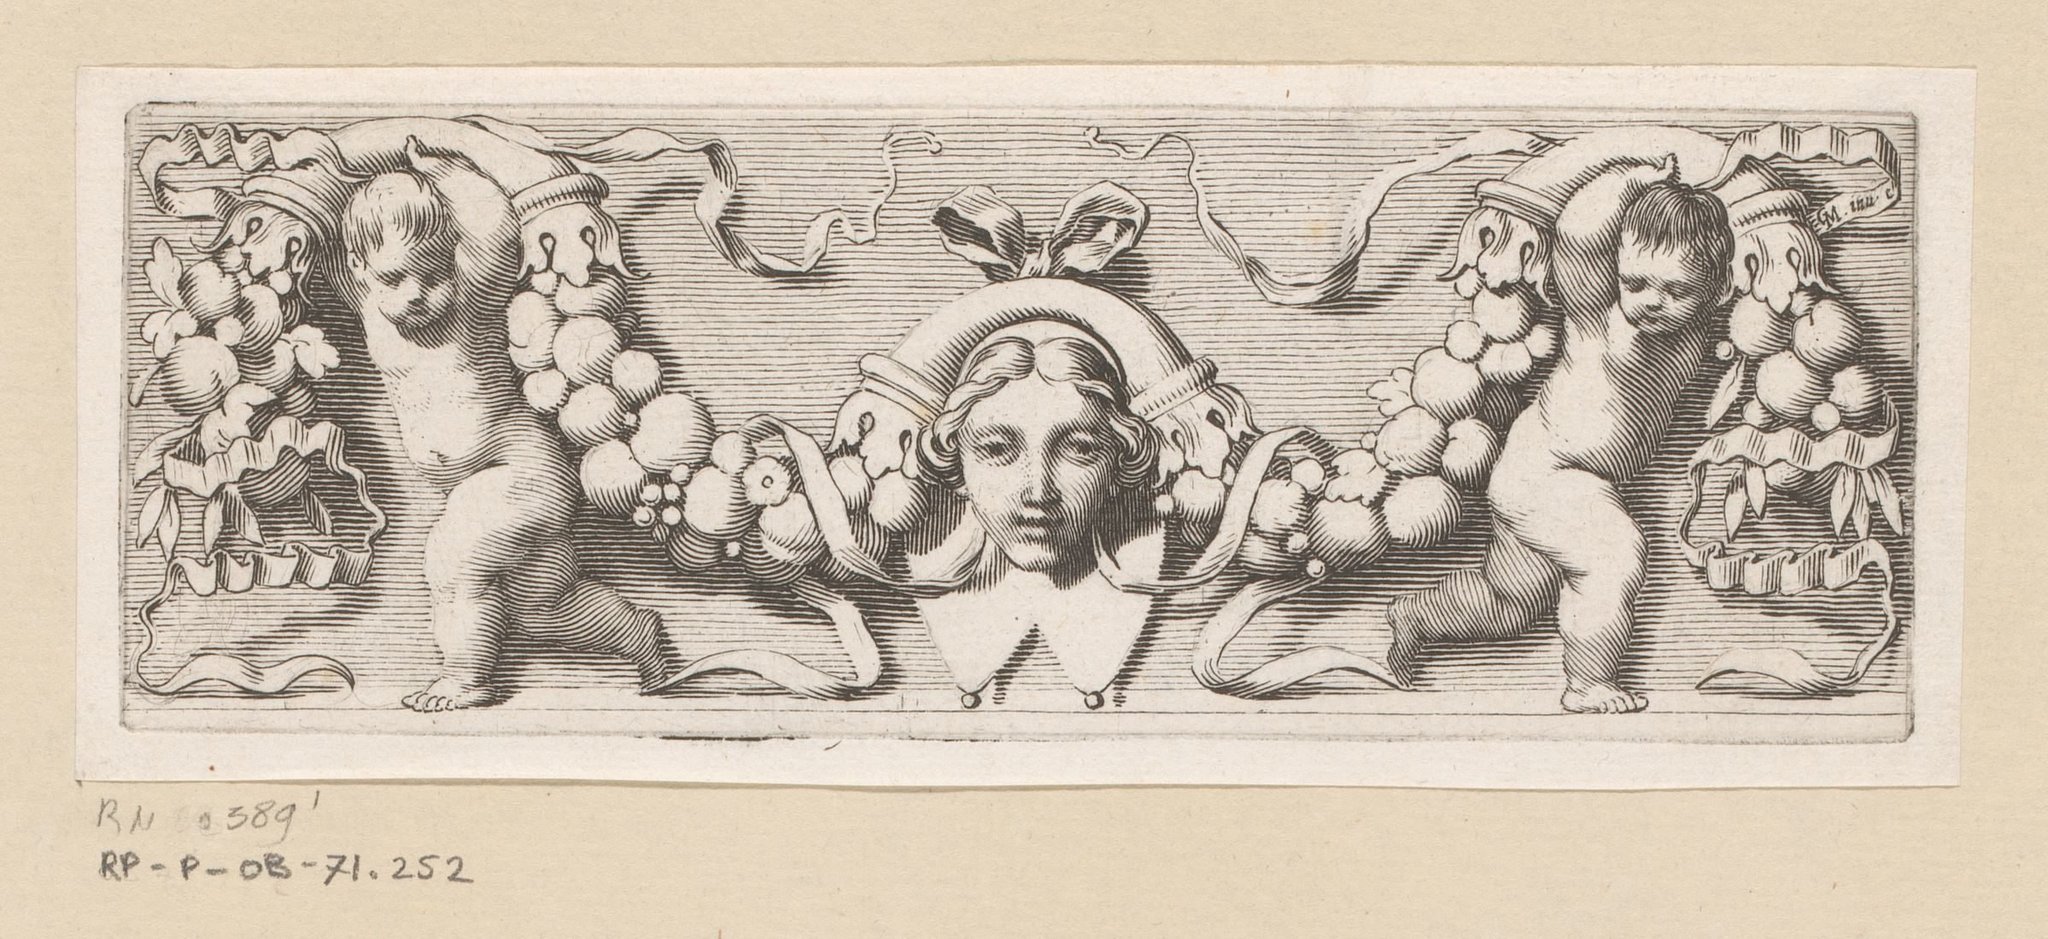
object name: print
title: Twee putti met een guirlande van fruit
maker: claude mellan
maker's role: draughtsman, print maker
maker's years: 1598-1688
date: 1639-1643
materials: paper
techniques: engraving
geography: paris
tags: ornament ~ festoon, garland, cupids: 'amores', 'amoretti', 'putti'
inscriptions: collector's mark: Lugt 240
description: Mellan ontwierp deze band waarschijnlijk voor de Imprimerie Royale. Tussen 1639-1643 werkte Mellan samen met de Imprimerie Royale (IFF 17e siècle, p. 21-22). Hij vervaardigde verschillende vignetten, letters, culs-de-lampe en decoratieve banden (IFF 17e siècle, p. 215-220).